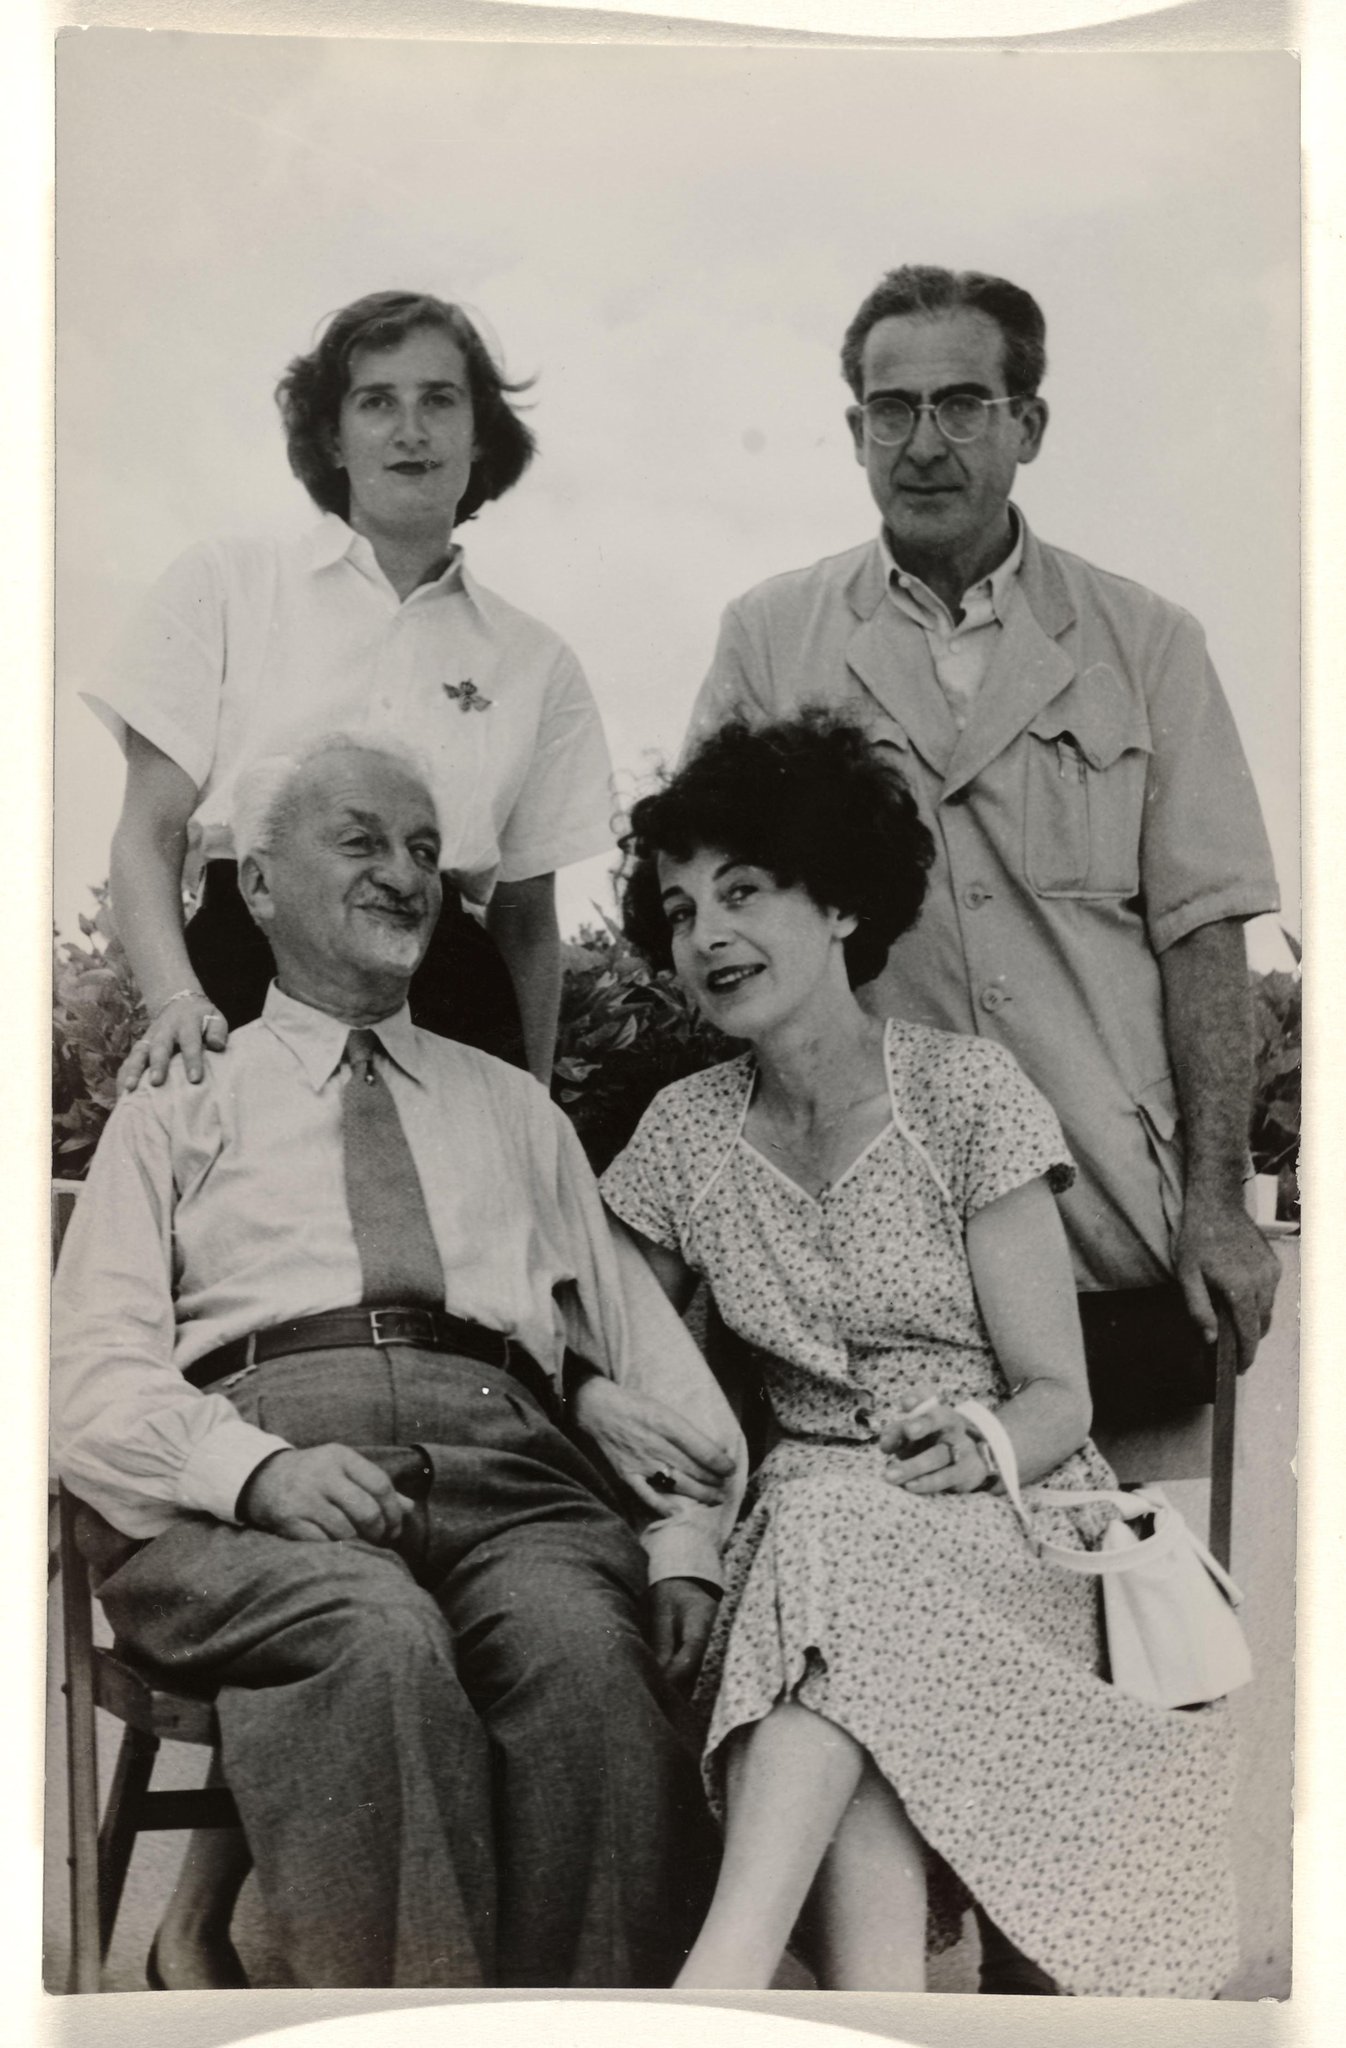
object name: photograph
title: Isabel Wachenheimer staand in het uniform van de KLM met KLM-insigne op de borst, met drie onbekende personen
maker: Anonymous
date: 1951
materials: photographic support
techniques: gelatin silver print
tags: leiden, isabel wachenheimer-elon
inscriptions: inscription: ‘Lydda airport Photographer, Israël’